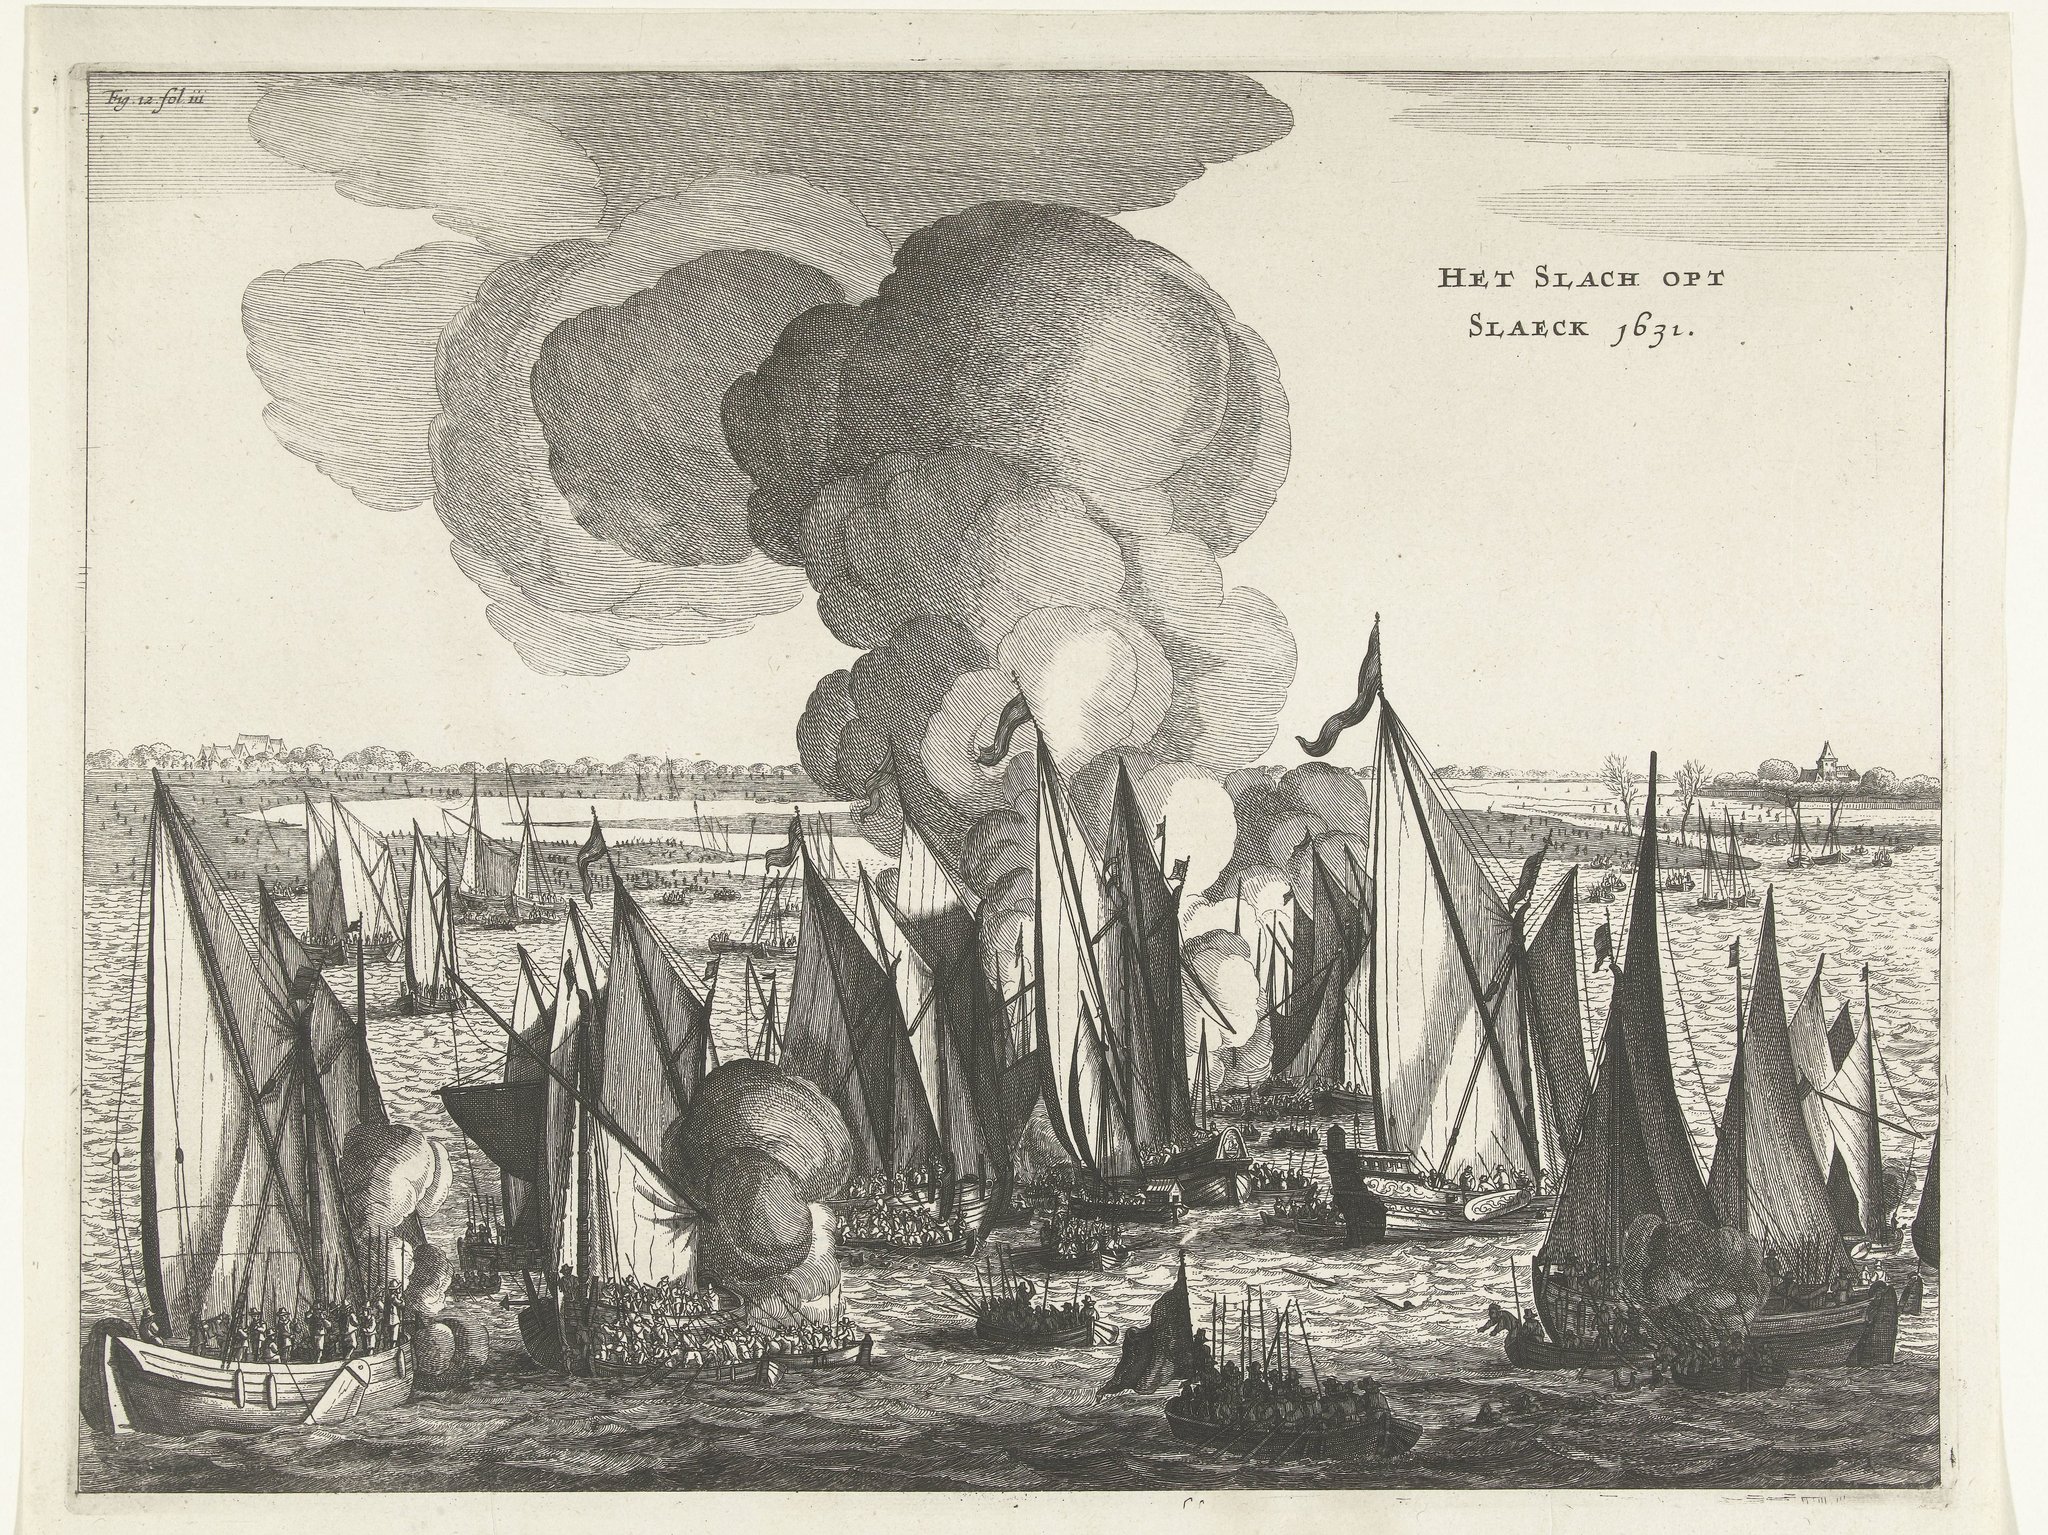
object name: print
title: Het Slach opt Slaeck 1631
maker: Anonymous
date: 1649-1651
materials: paper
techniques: etching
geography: northern netherlands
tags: battle (+ naval force)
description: De slag op het Slaak, 12-13 september 1631, tussen de Staatse en Spaanse vloten. Gemerkt linksboven: fig. 12, fol. 111. De Staatse vloot onder bevel van vice-admiraal Marinus Hollare.